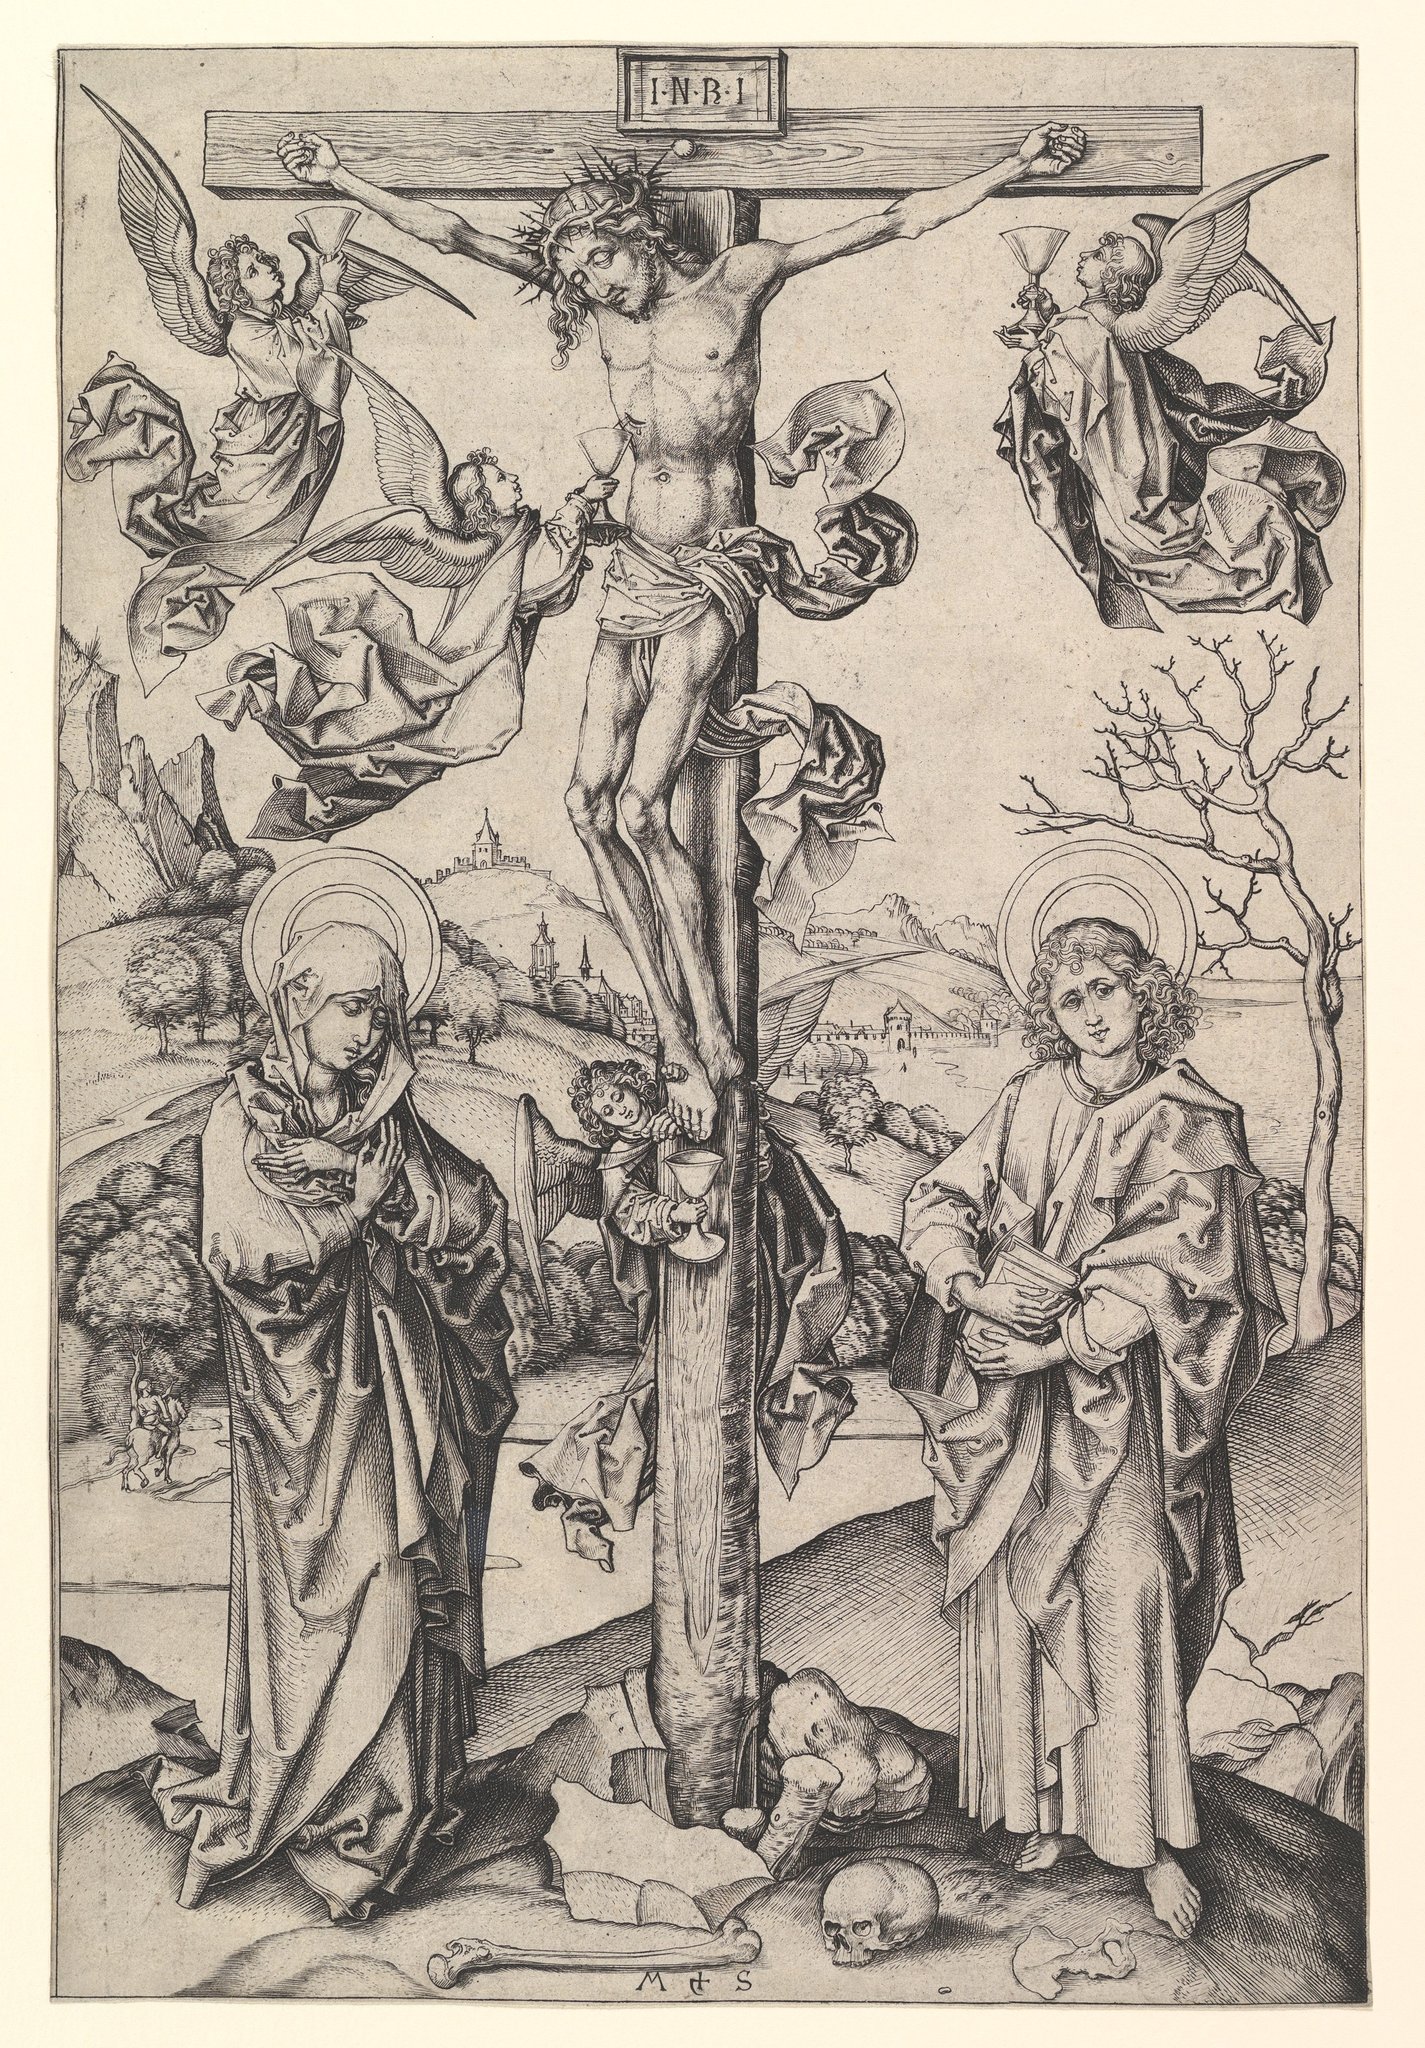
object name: print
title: Crucifixion with Four Angels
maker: martin schongauer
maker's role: artist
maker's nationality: german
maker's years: 1430-1491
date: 1475-1480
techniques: engraving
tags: angels,jesus,crucifixion